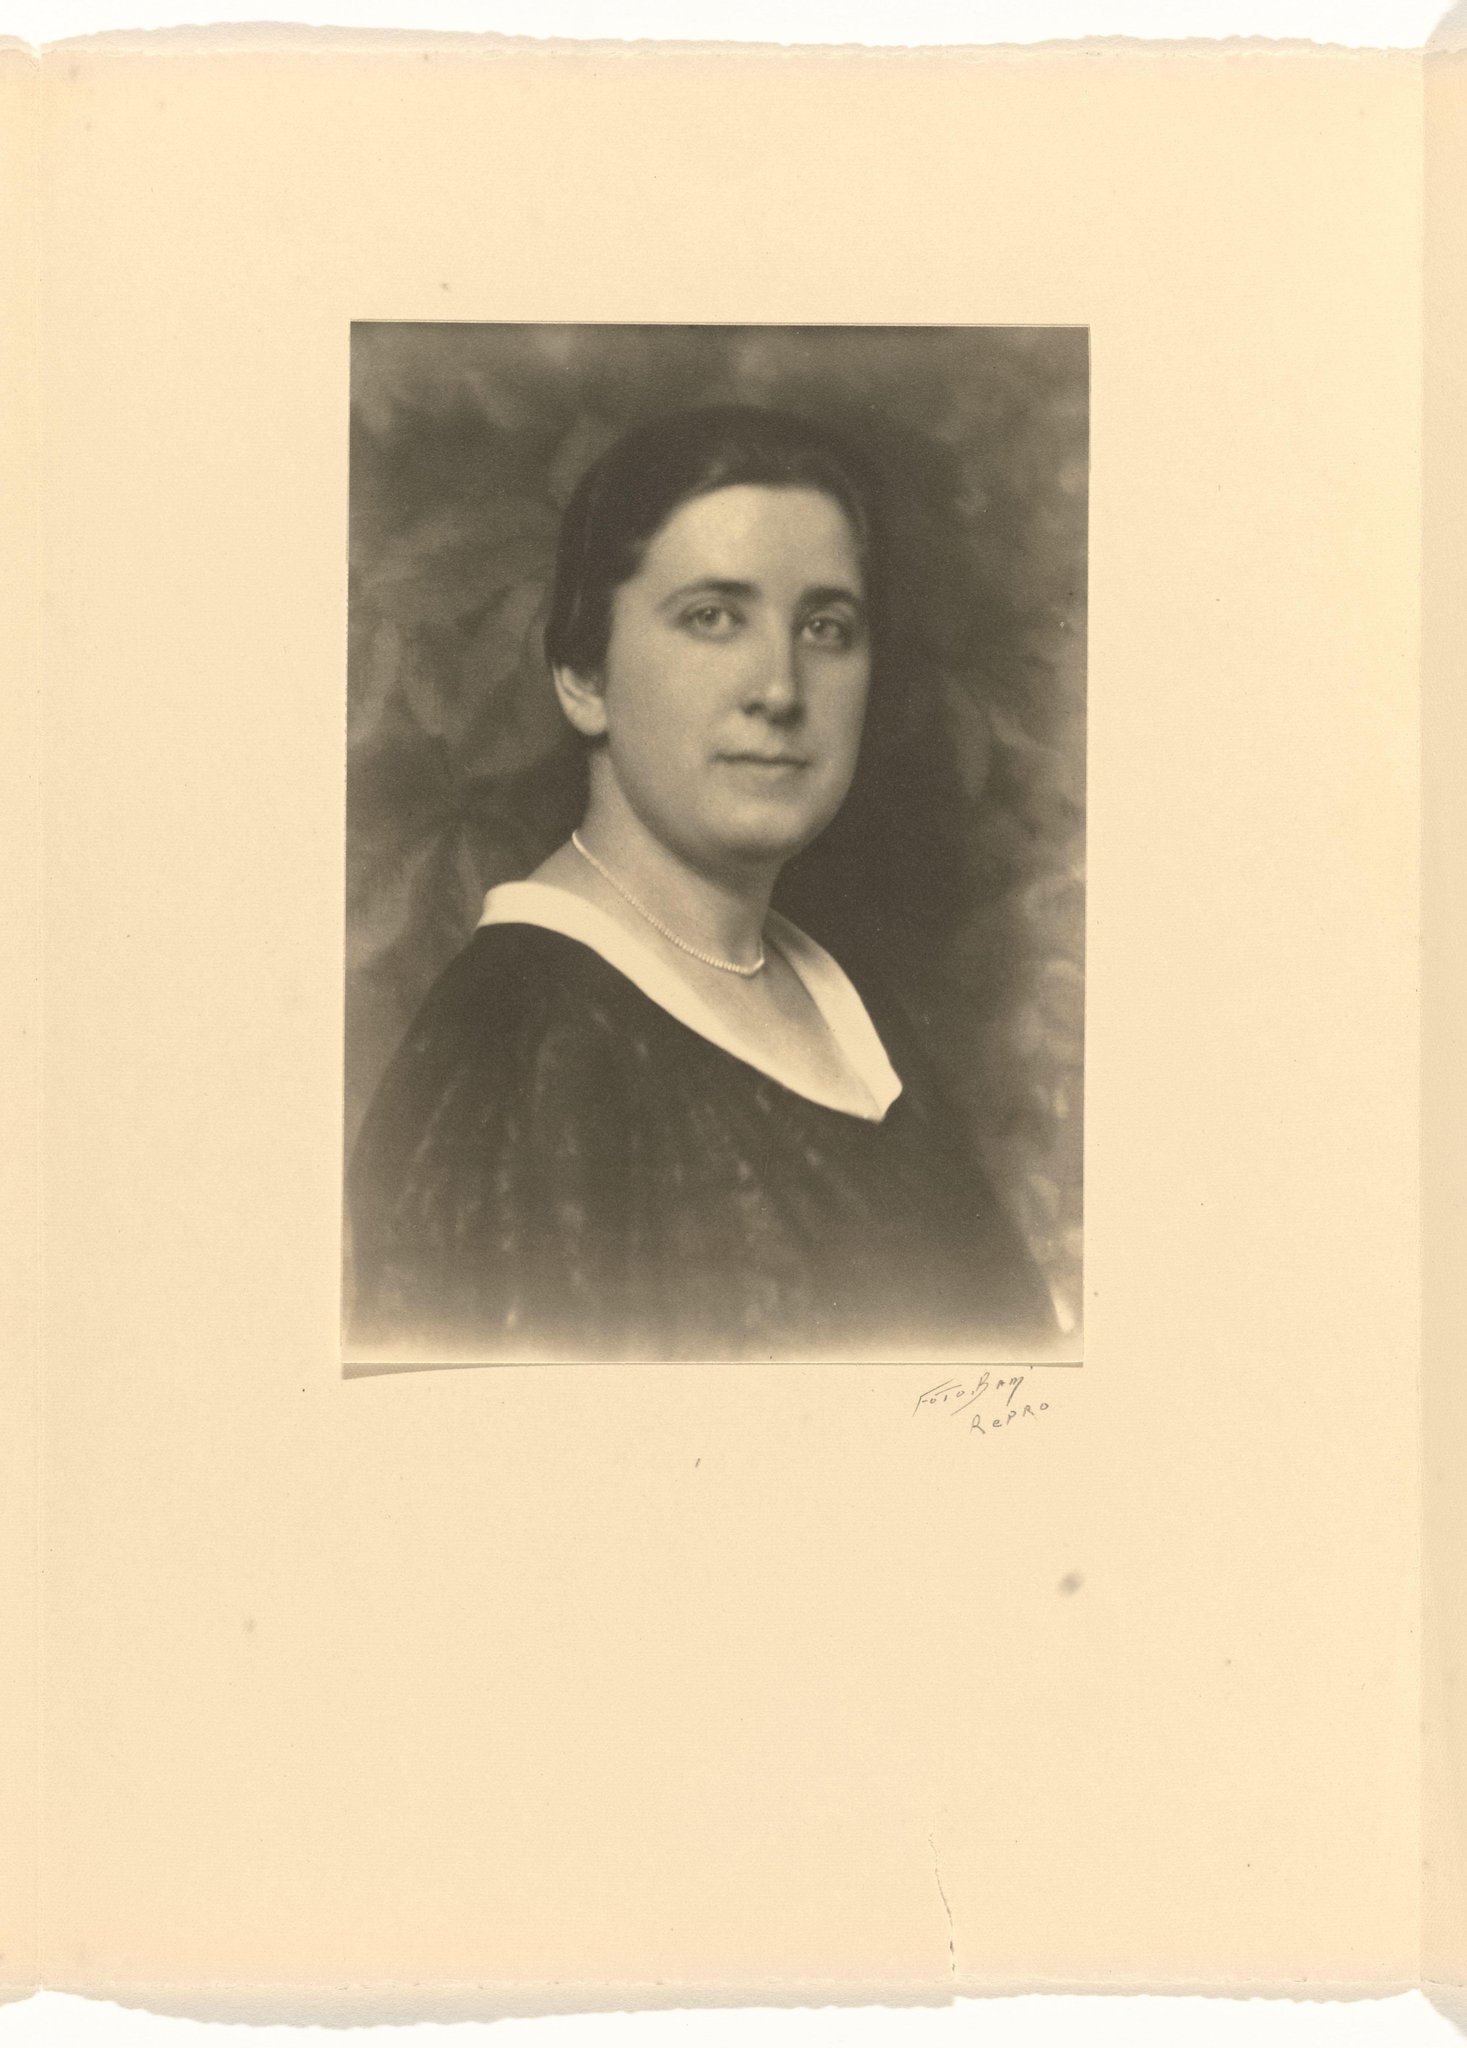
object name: photograph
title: Portret van Else Moos-Wachenheimer in donkere kleding met lichte kraag, Lugano, 1924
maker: Anonymous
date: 1924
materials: photographic support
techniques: gelatin silver print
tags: else wachenheimer-moos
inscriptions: company name: ‘Foto. Bam Repro’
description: Portret van Else Wachenheimer-Moos in donkere kleding met lichte kraag.